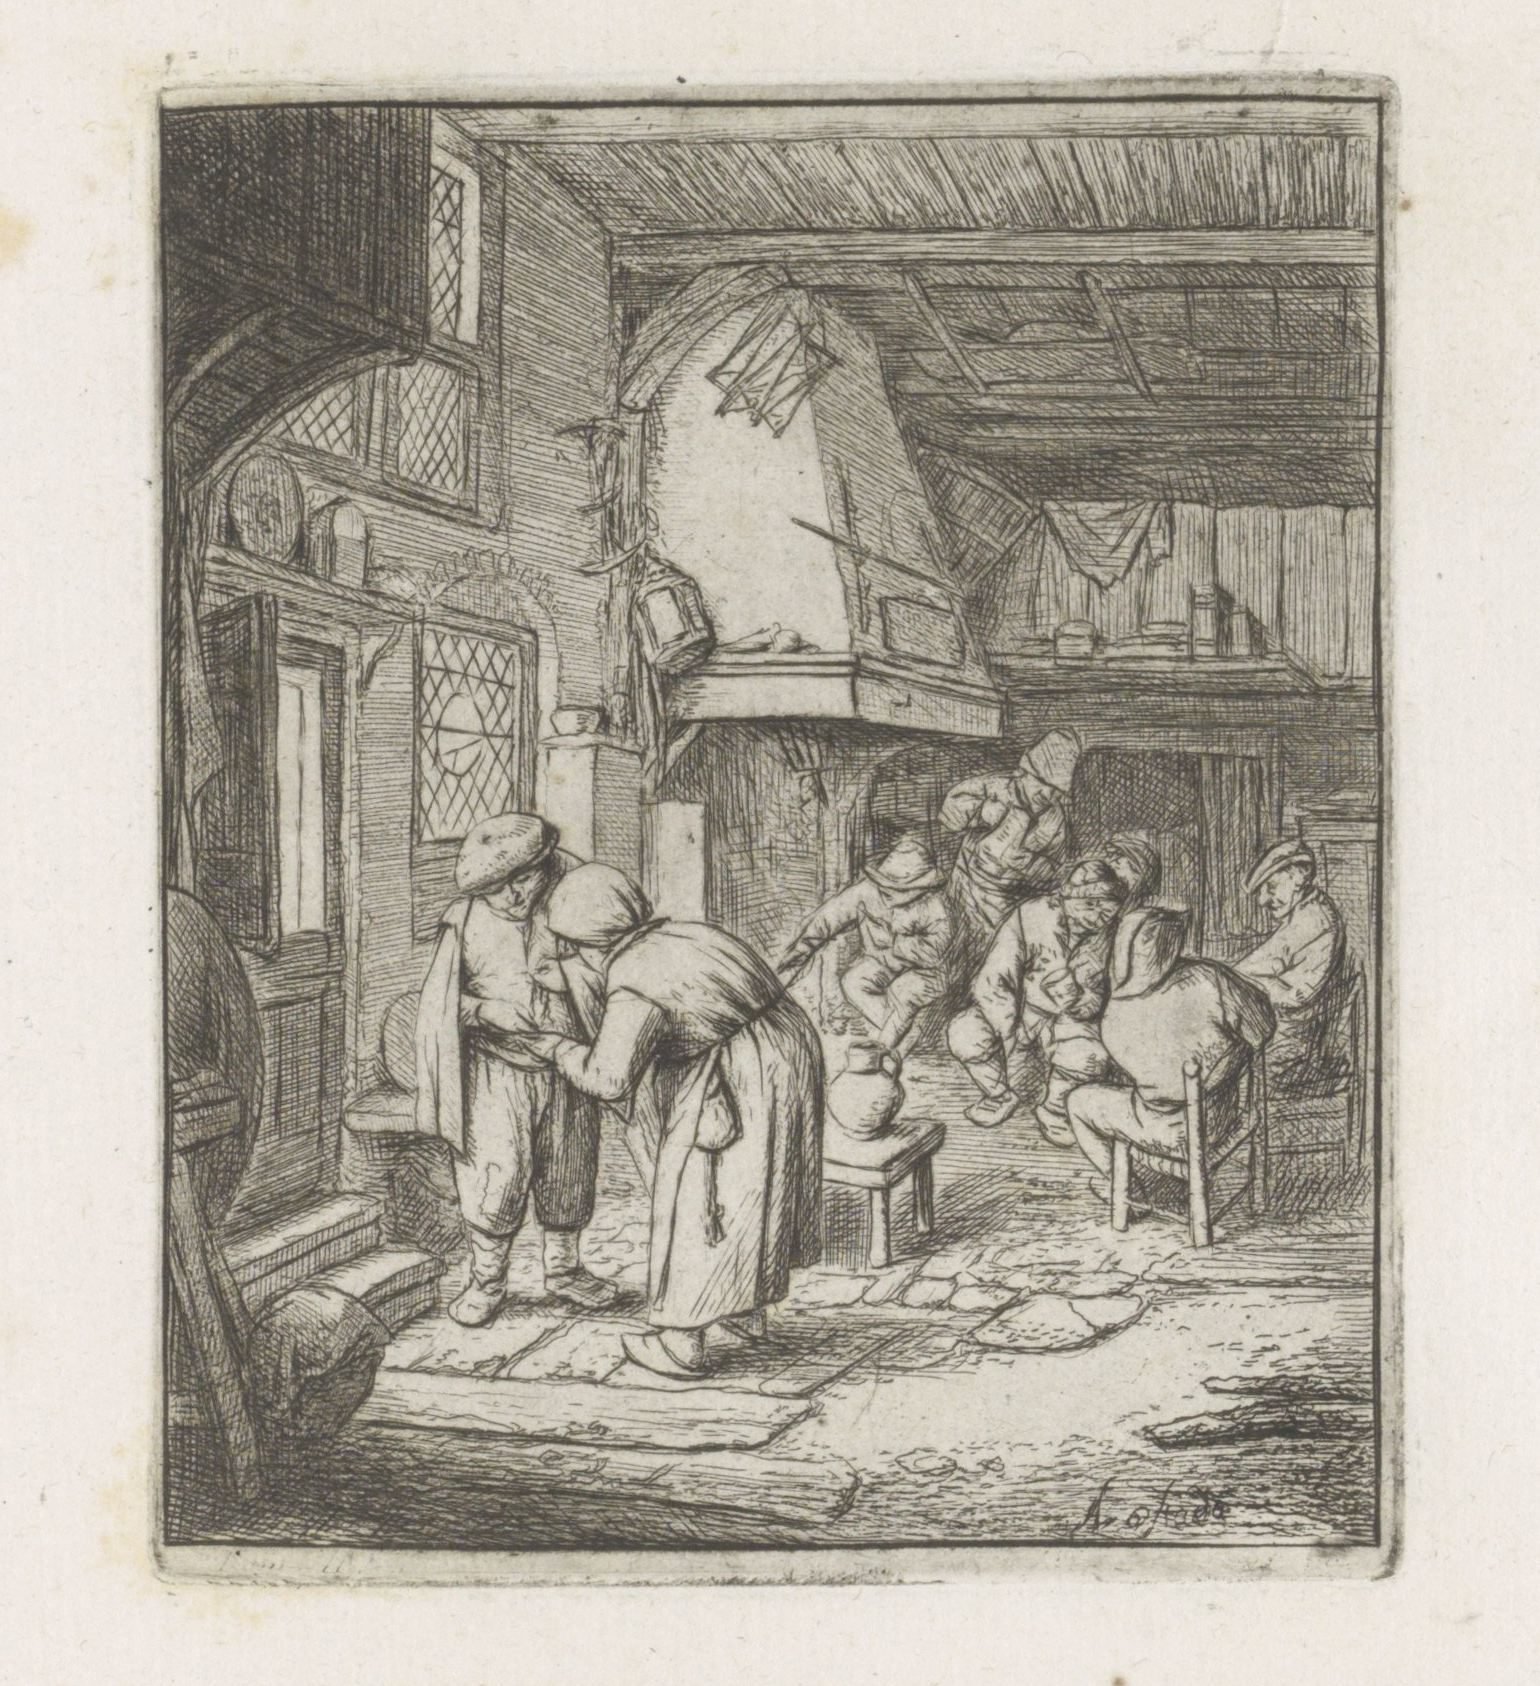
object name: album leaf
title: Man betaalt een vrouw in een herberg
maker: adriaen van ostade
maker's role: draughtsman, painter, print maker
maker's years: 1610-1685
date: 1648-1653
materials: paper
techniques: etching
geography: haarlem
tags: paying (~ commerce) (here also repayment of debt, etc.), inn, coffee-house, public house, etc.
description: Interieur van een herberg met een man die zijn gemaakte kosten afrekent met een vrouw. Bij de haard zit een groep mannen. Deze prent maakt deel uit van een album.